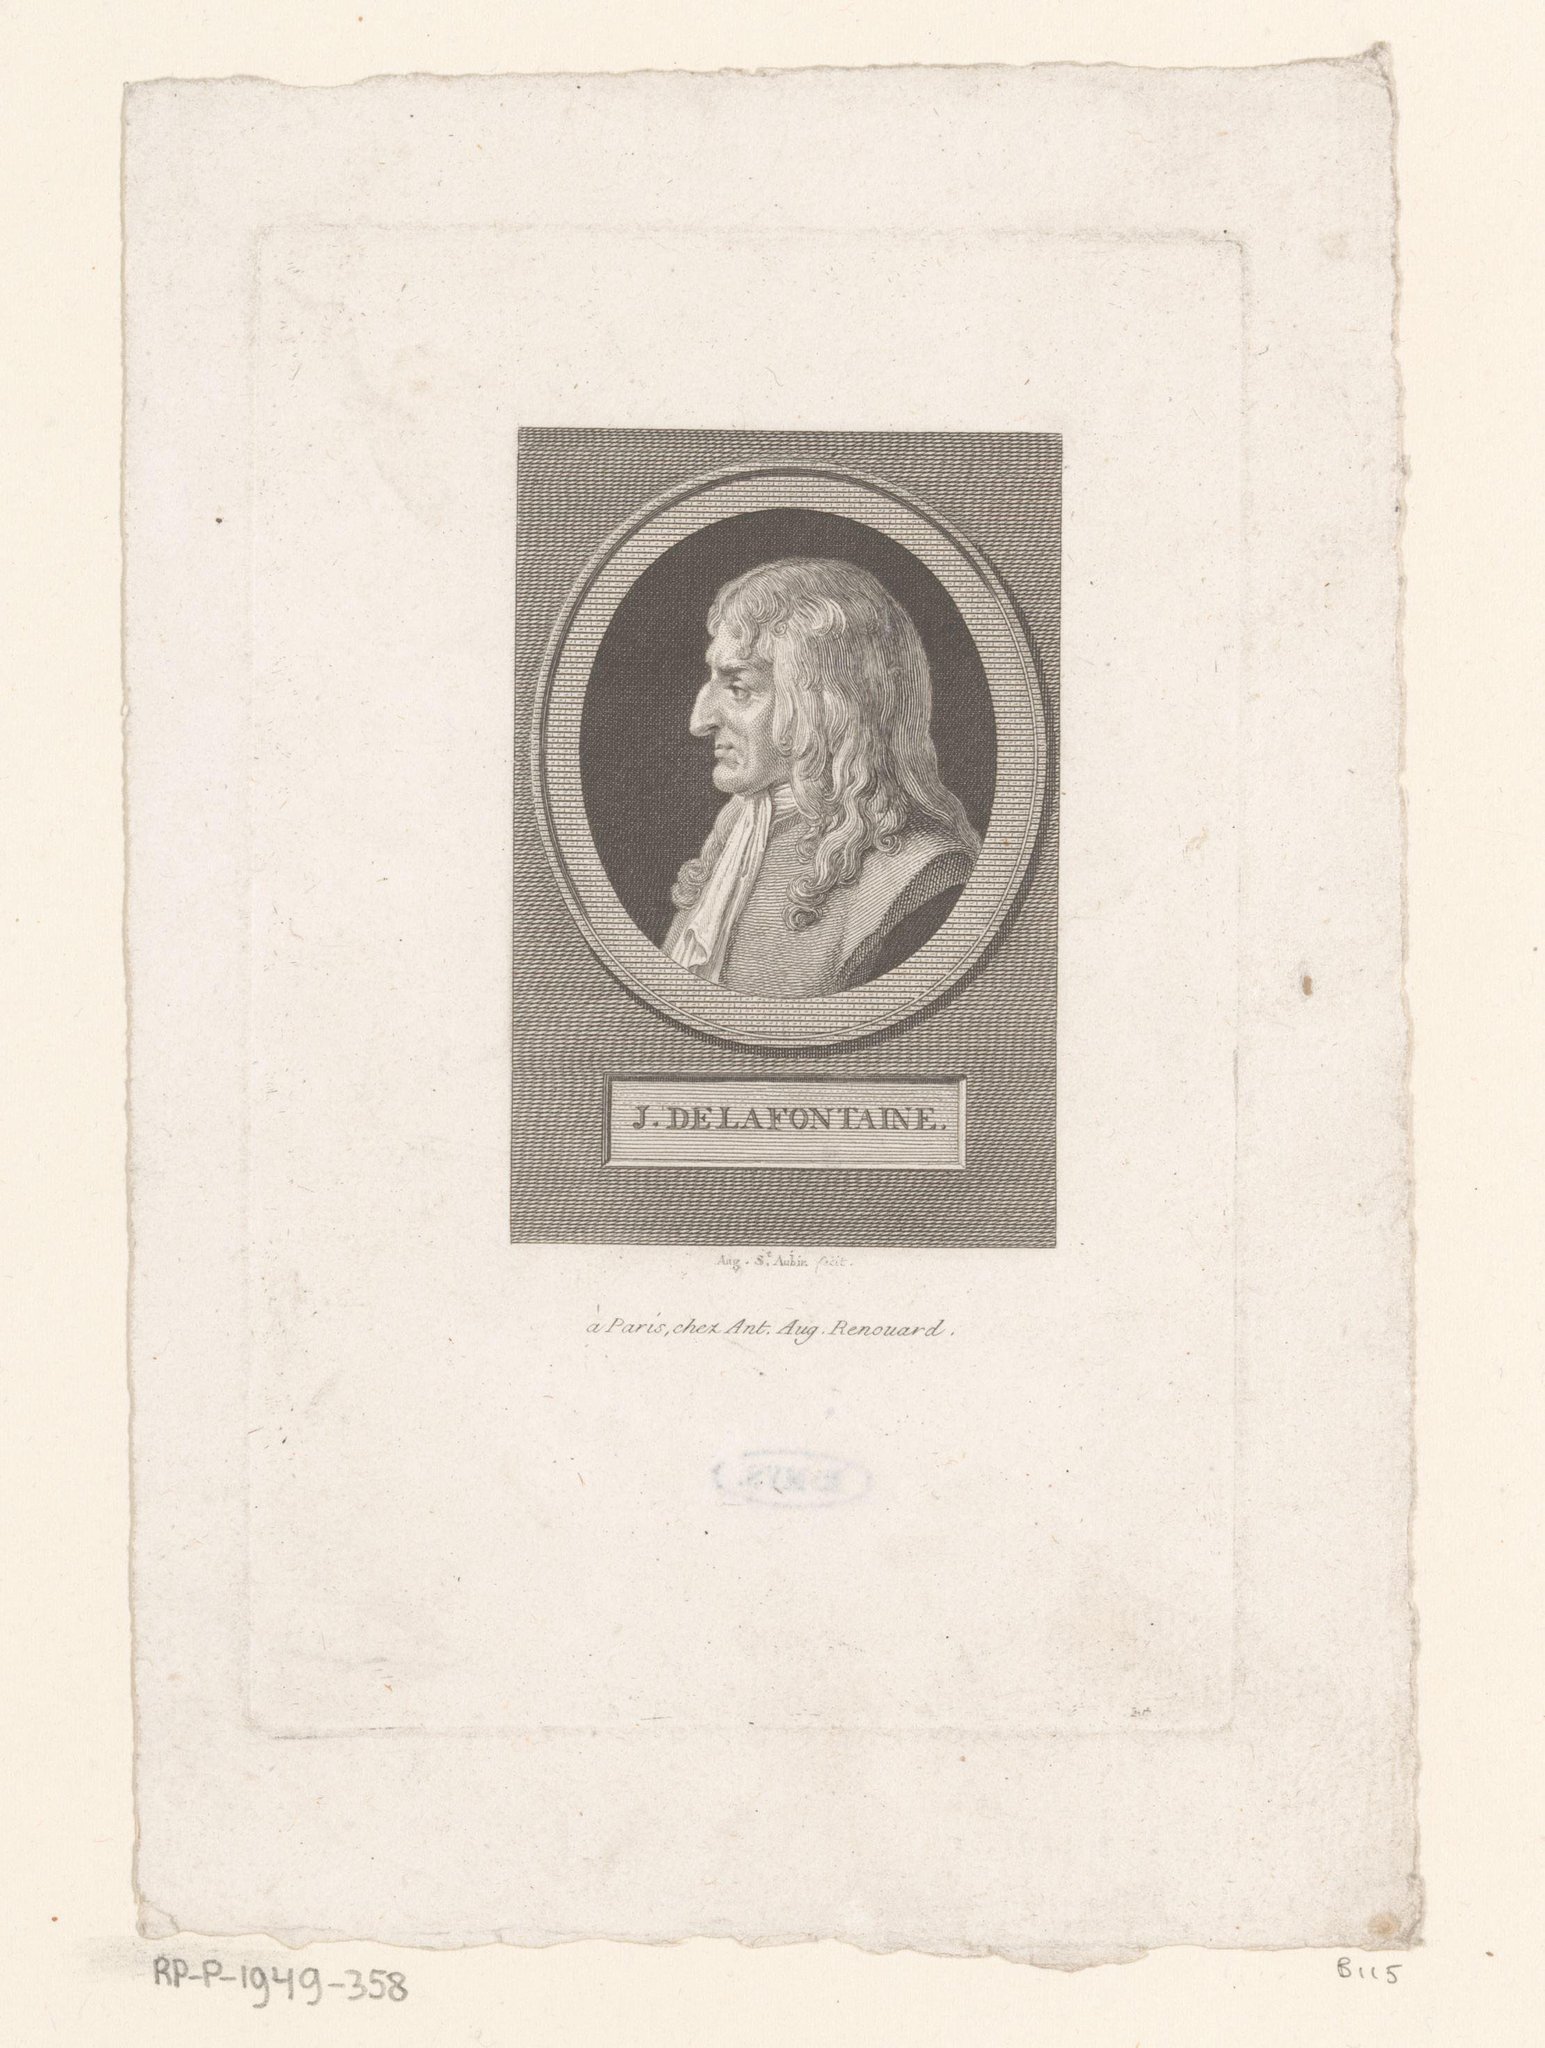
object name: print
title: Portret van Jean de La Fontaine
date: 1801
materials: paper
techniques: engraving, etching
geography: paris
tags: paris, jean de la fontaine, historical persons, portrait of a writer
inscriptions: collector's mark: Lugt 2228